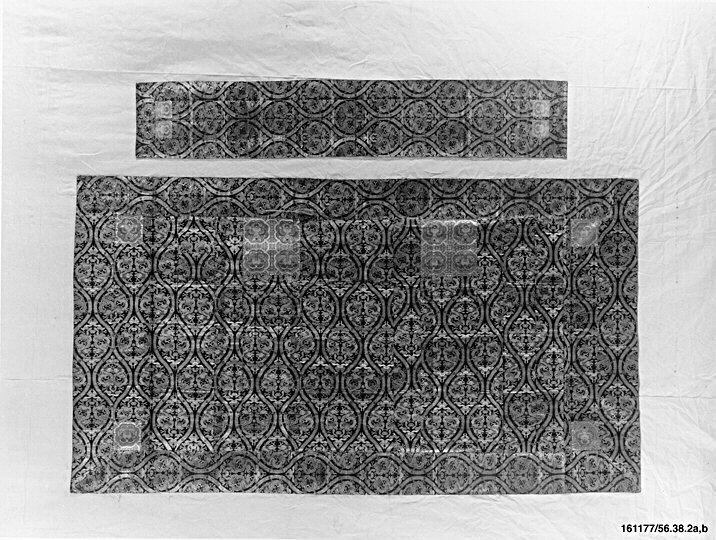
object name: robe, priest's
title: Priest's Robe and Stole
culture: japanese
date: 1701-1800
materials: metal thread, silk